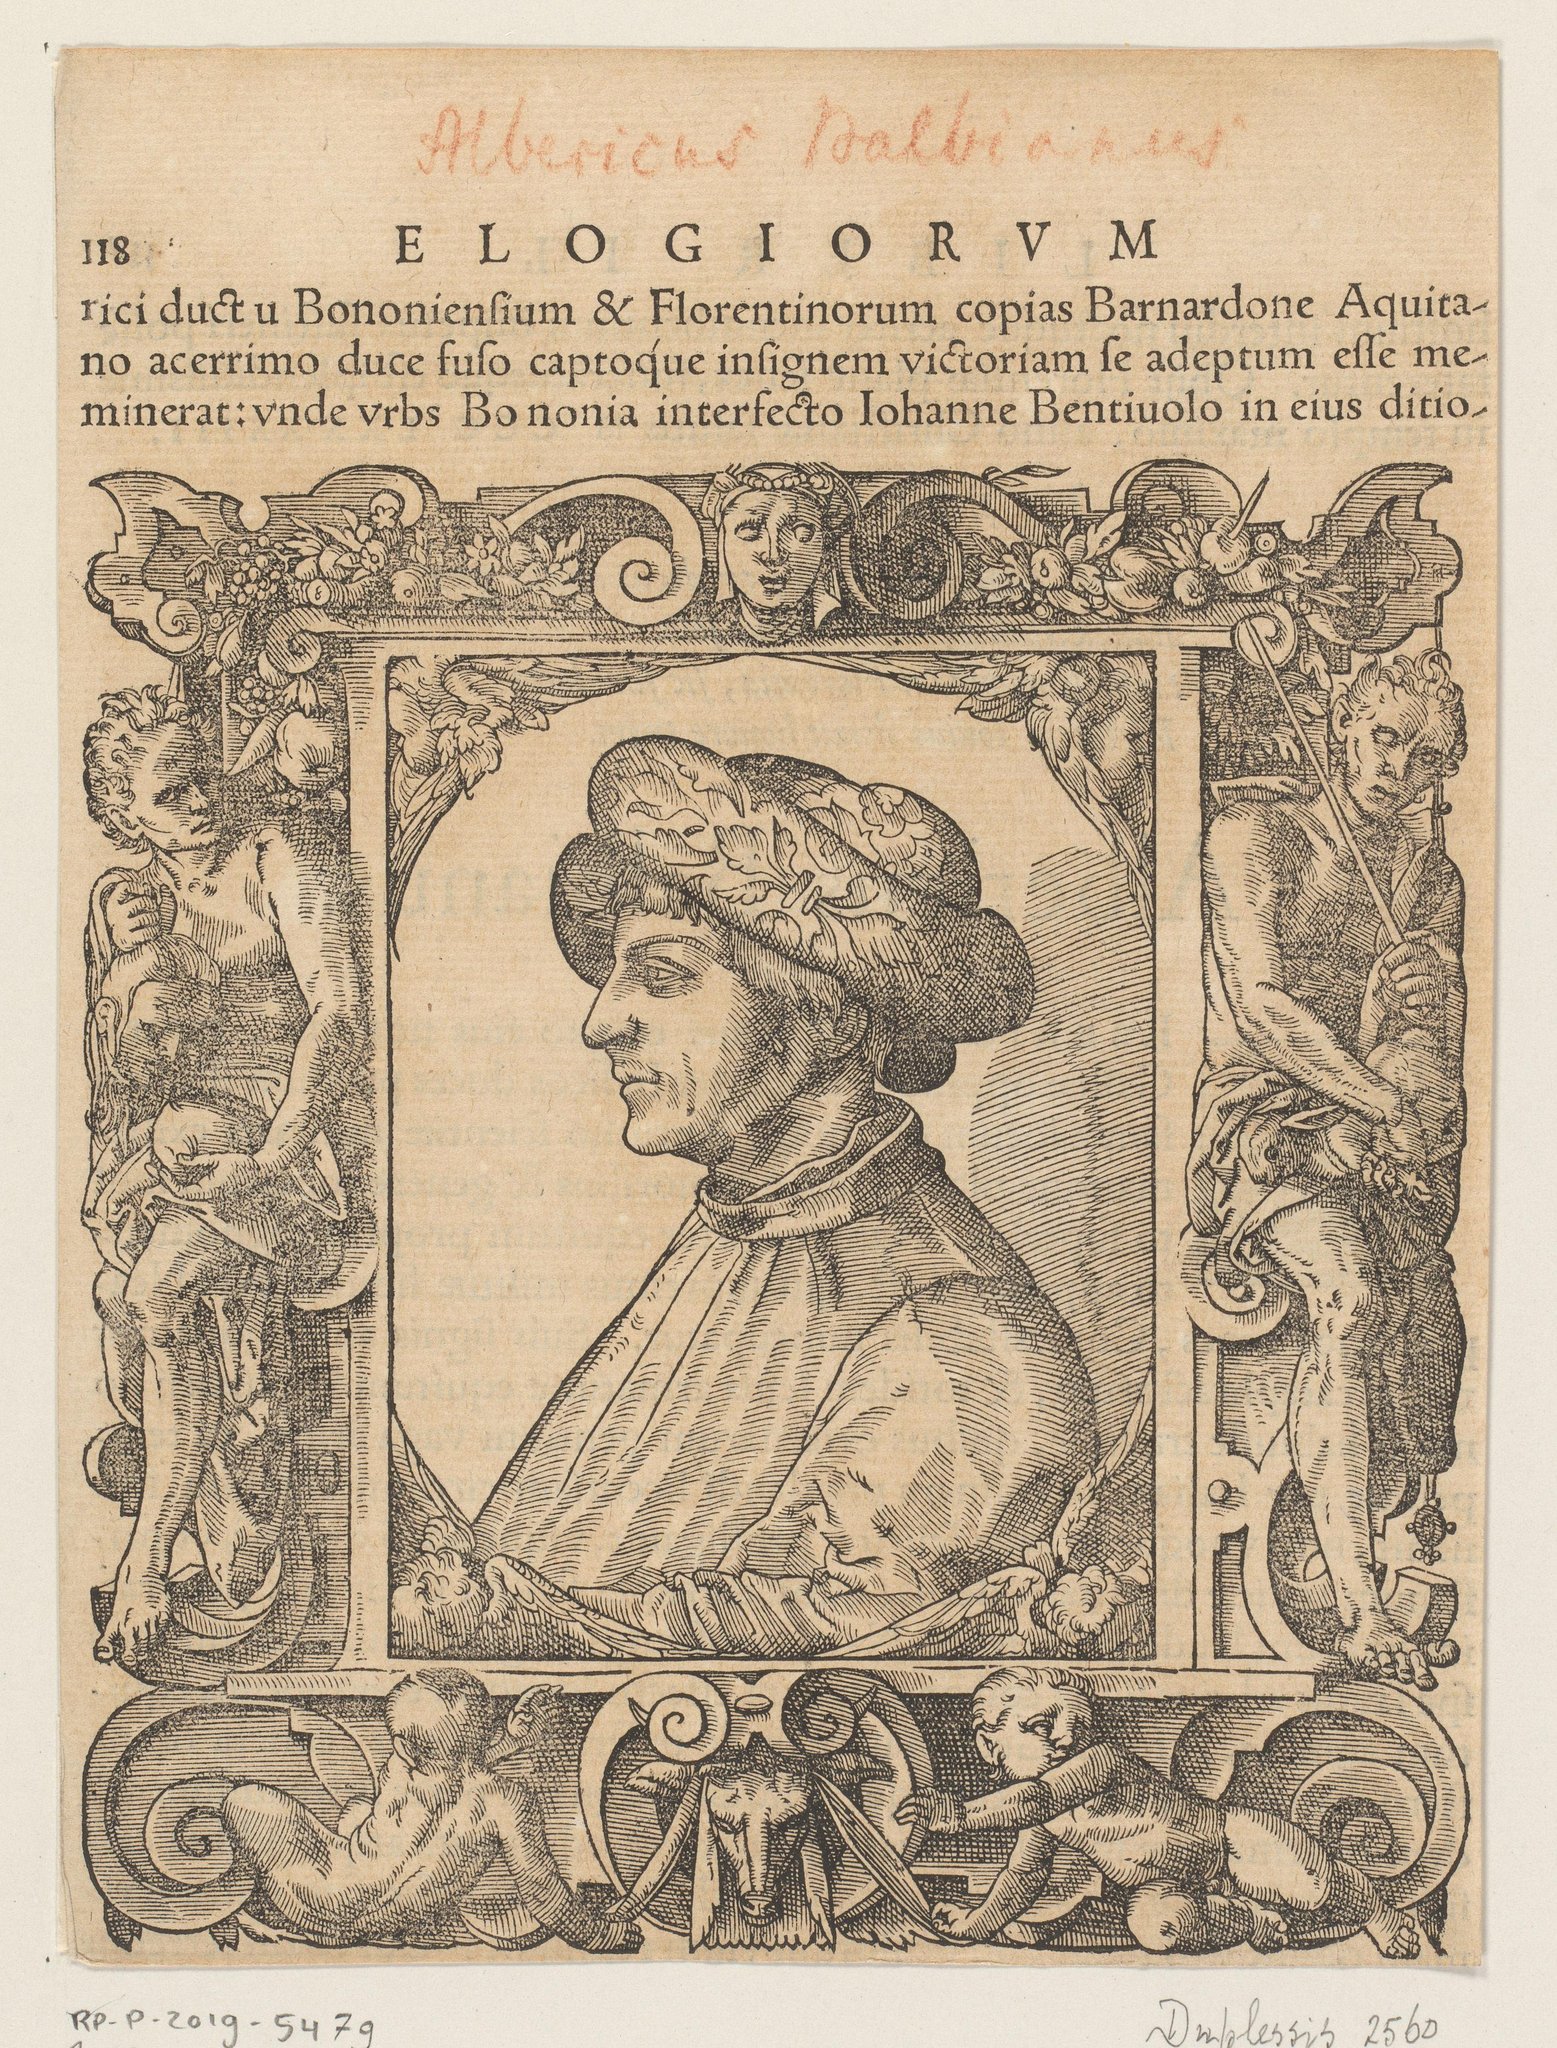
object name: print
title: Portret van Alberico da Barbiano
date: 1575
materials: paper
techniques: letterpress printing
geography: basel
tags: historical persons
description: Prent uit: Giovio, Paolo. Elogia virorum bellica virtute illustrium (...). Bazel: Peter Perna, 1575, p. 118. Prent ook gebruikt in latere publicaties.